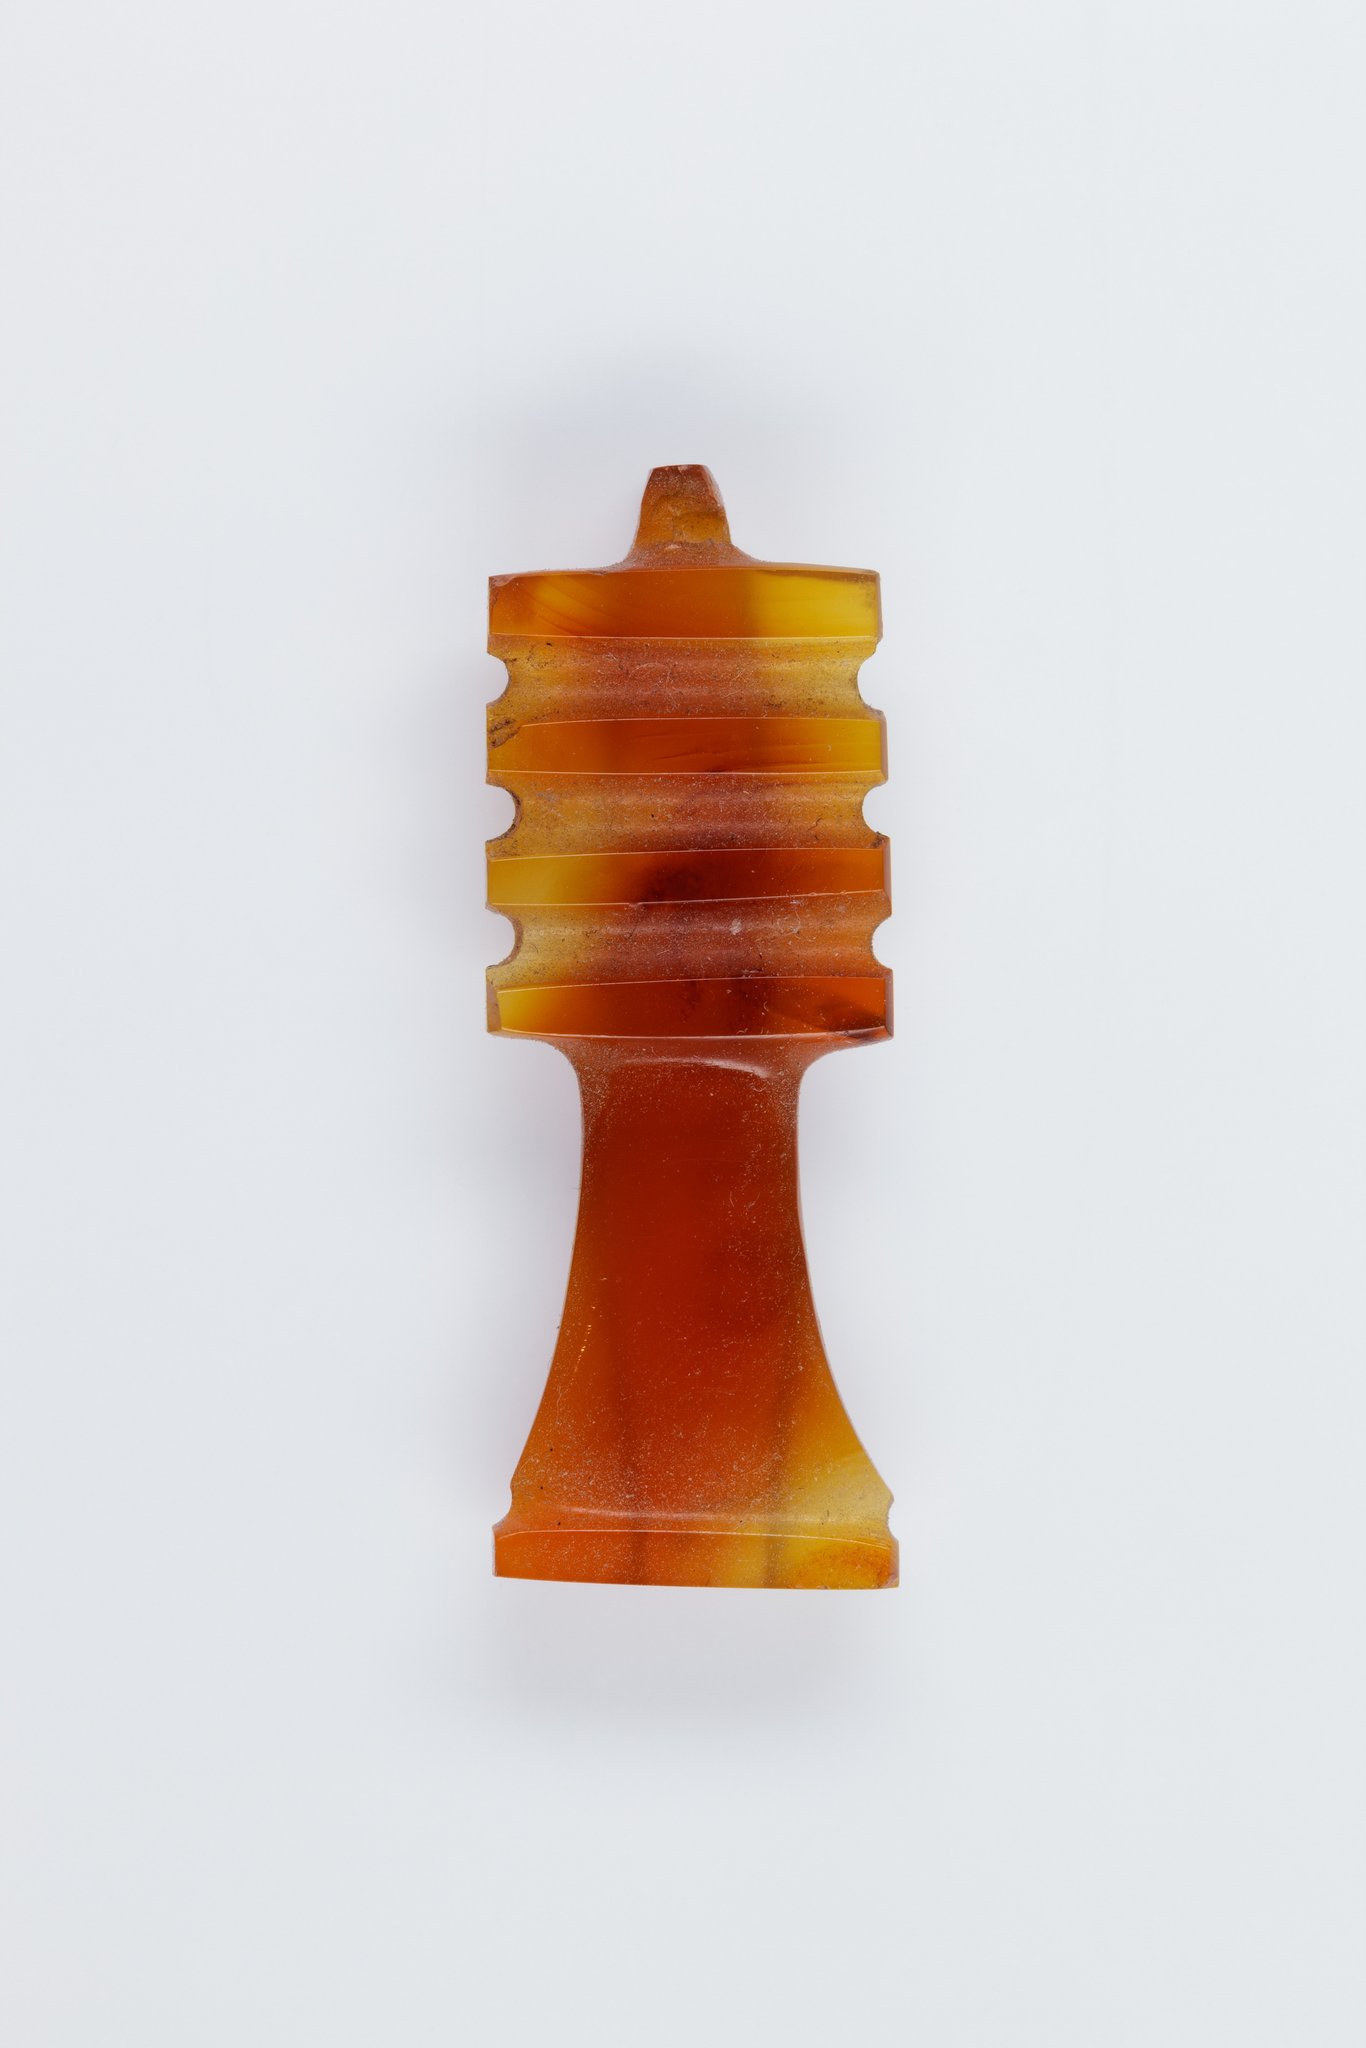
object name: amulet, djed pillar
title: Djed Amulet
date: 1295-1185 BCE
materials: gemstone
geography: egypt